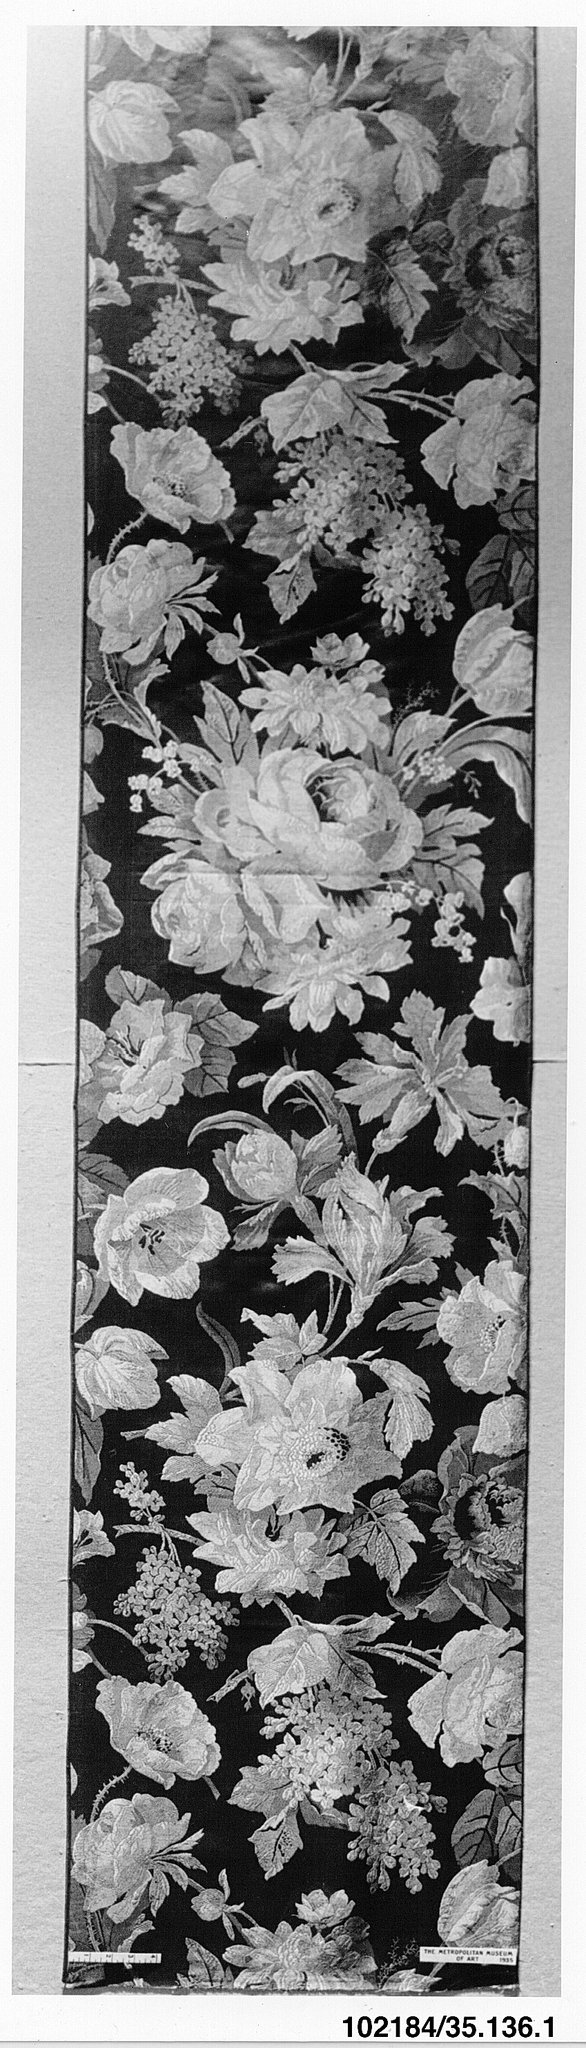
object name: piece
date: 1826-1850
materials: silk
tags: flowers